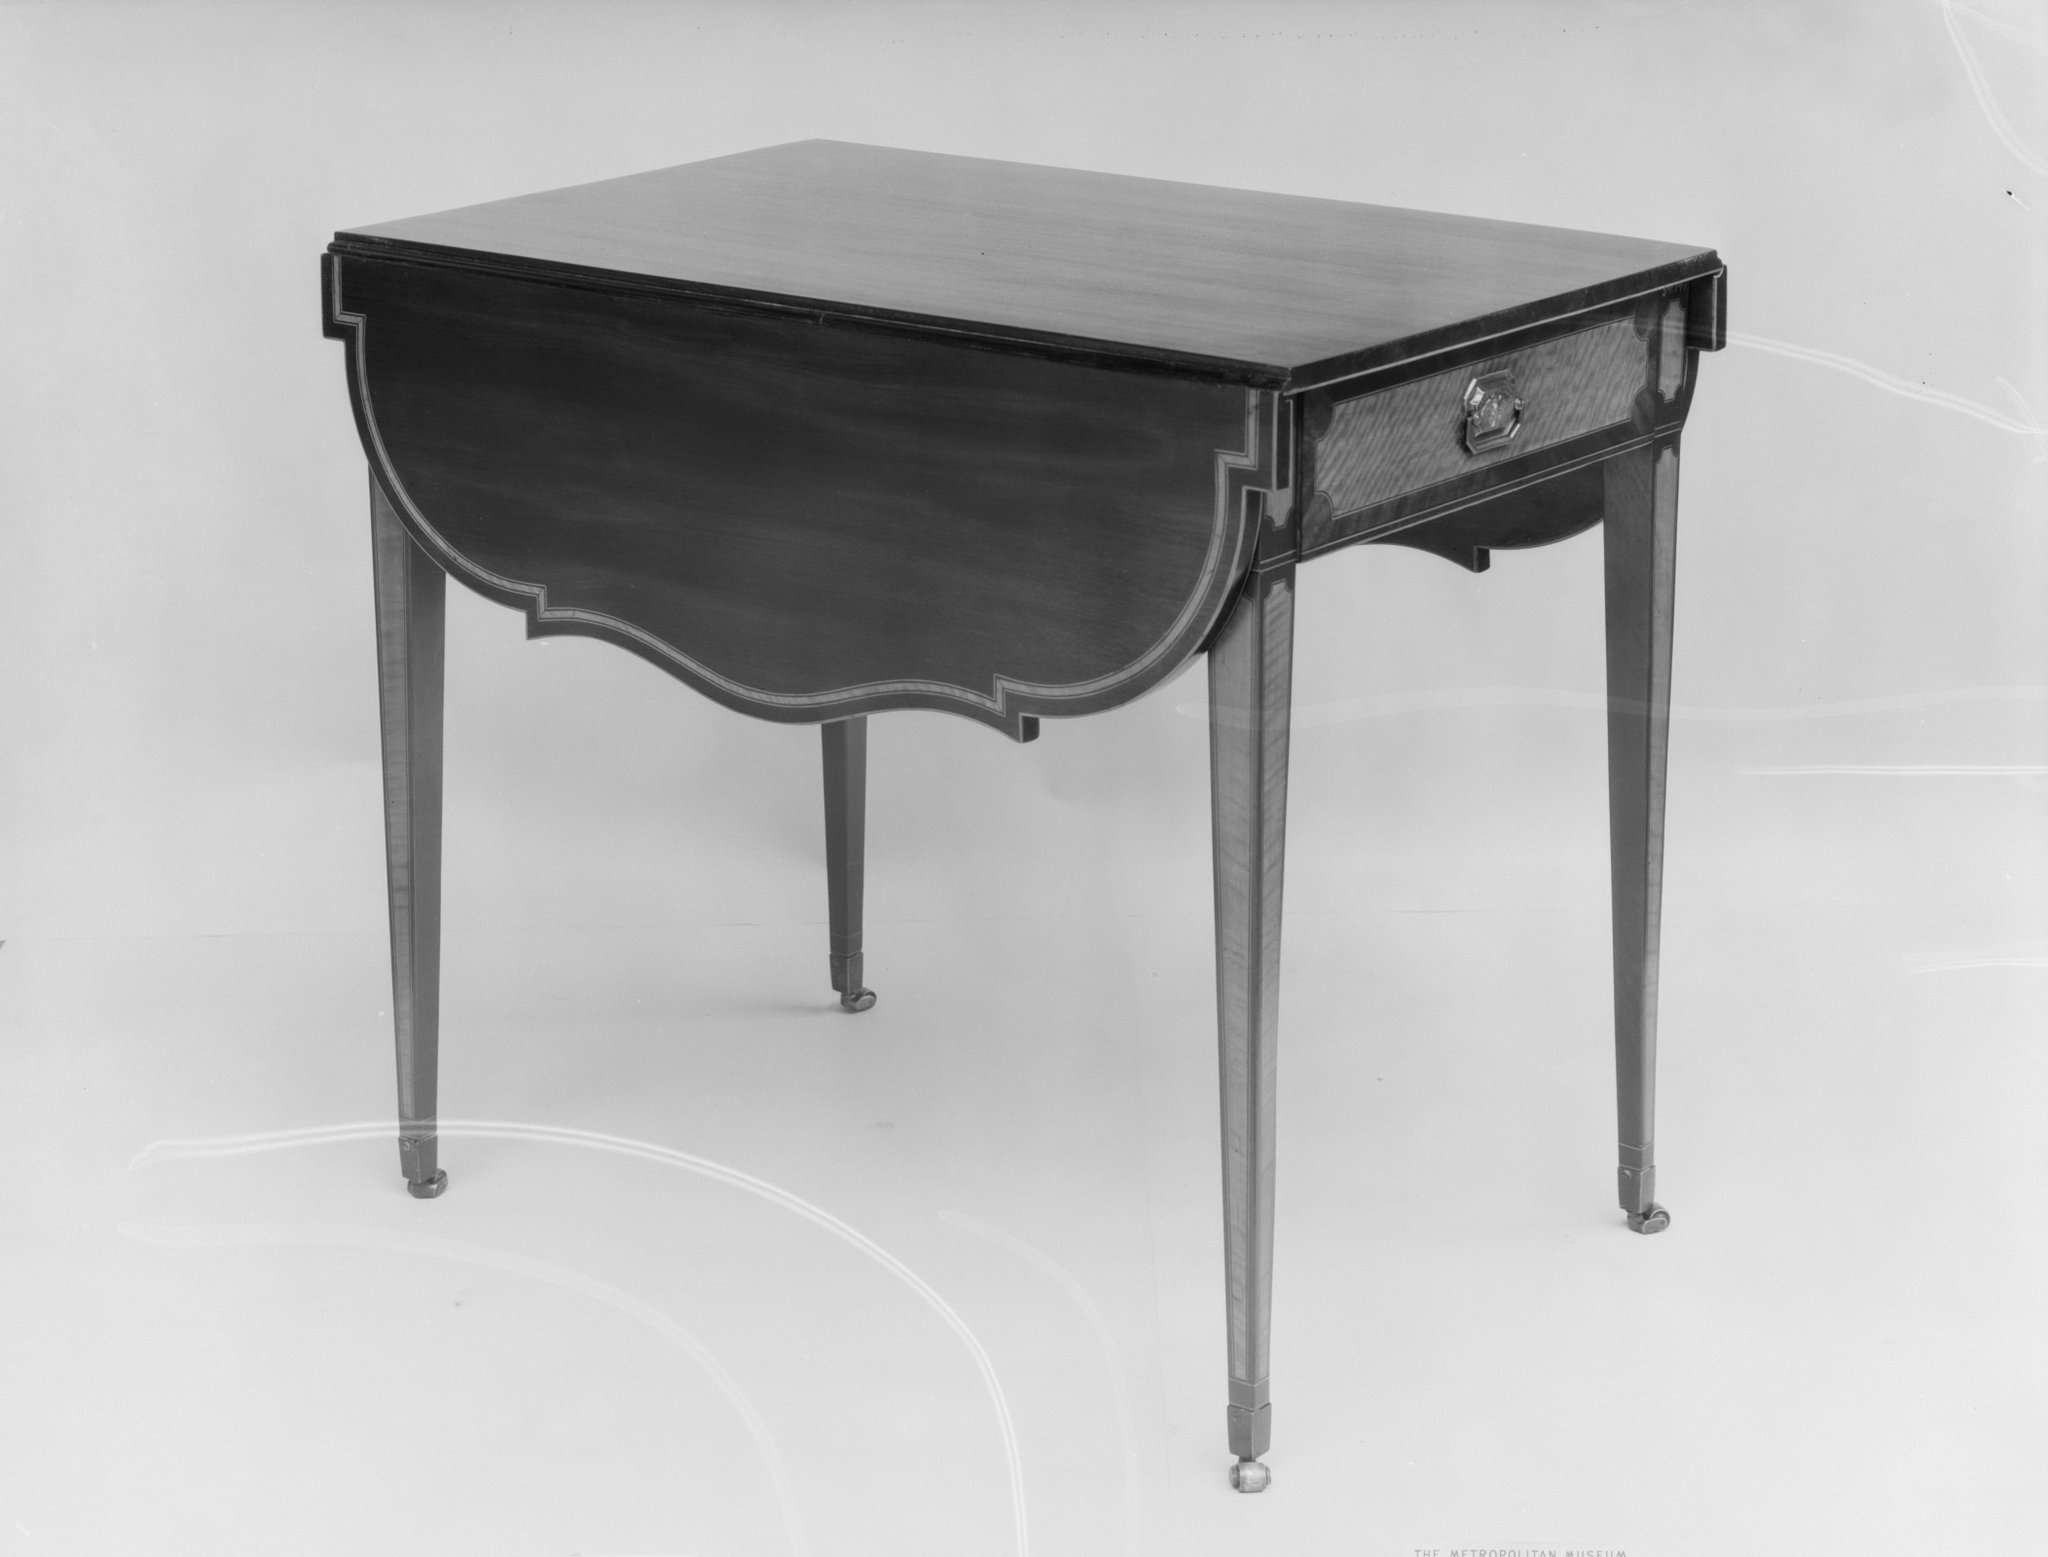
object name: drop leaf pembroke table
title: Drop-leaf Pembroke Table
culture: american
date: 1795-1810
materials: wood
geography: united states